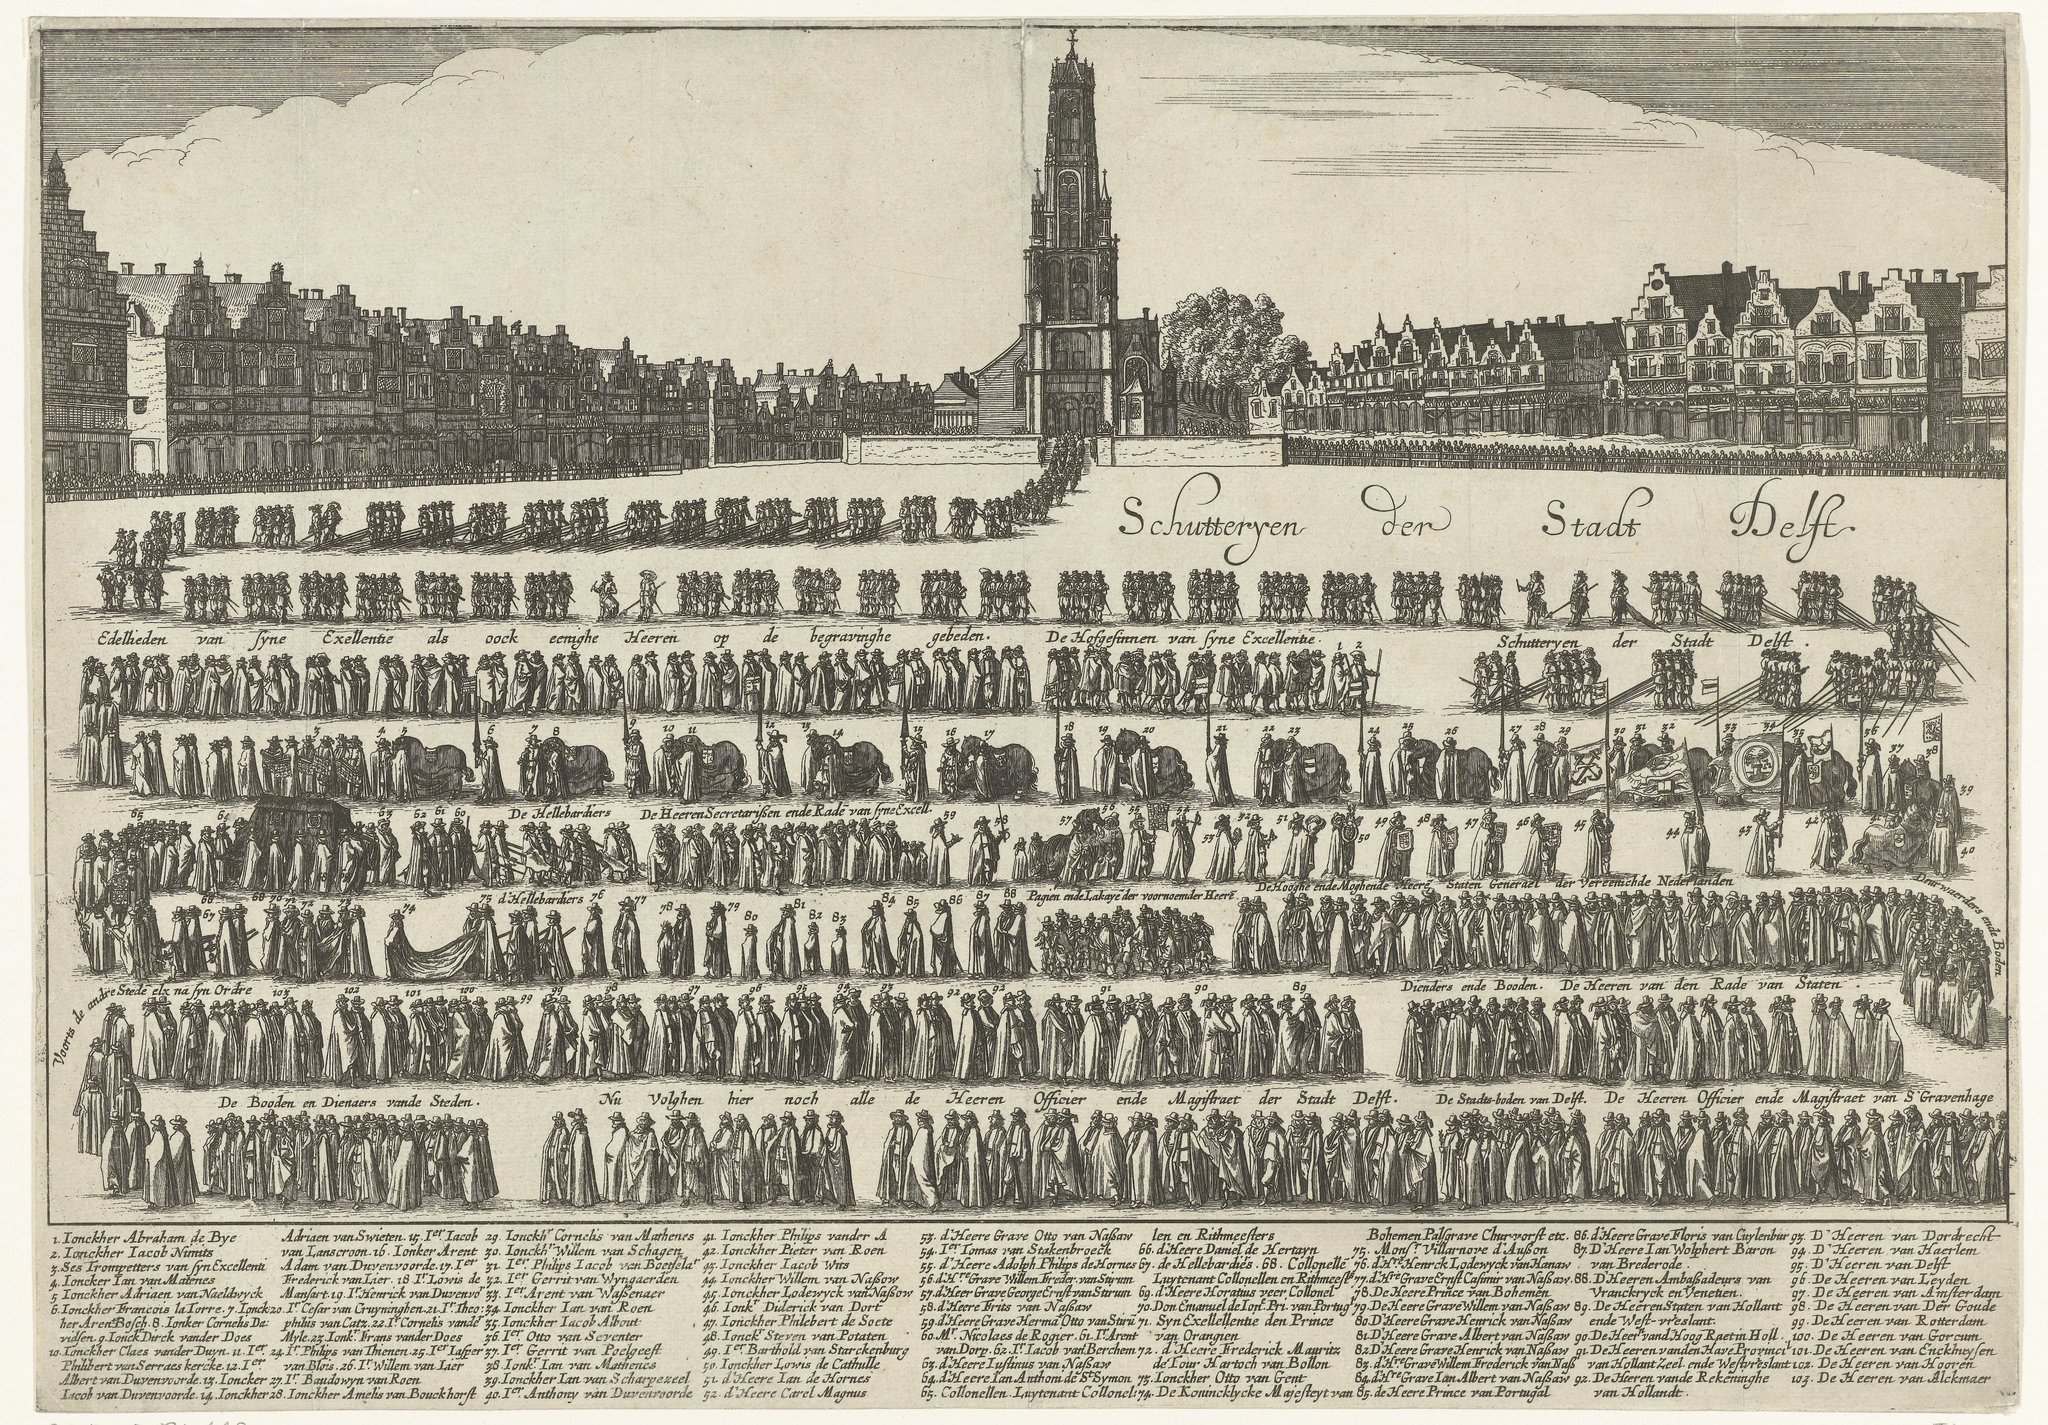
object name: print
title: Uitvaart van prins Maurits, 1625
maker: Anonymous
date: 1649-1651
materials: paper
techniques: etching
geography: northern netherlands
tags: maurice (prince of orange), cortege, funeral procession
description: De begrafenisstoet van prins Maurits te Delft op 16 september 1625. Een lange stoet slingert zich over de Grote Markt in acht rijen naar de ingang van de Nieuwe Kerk. Vooraan de schutterijen van de stad Delft. In het onderschrift de legenda 1-103 in het Nederlands.